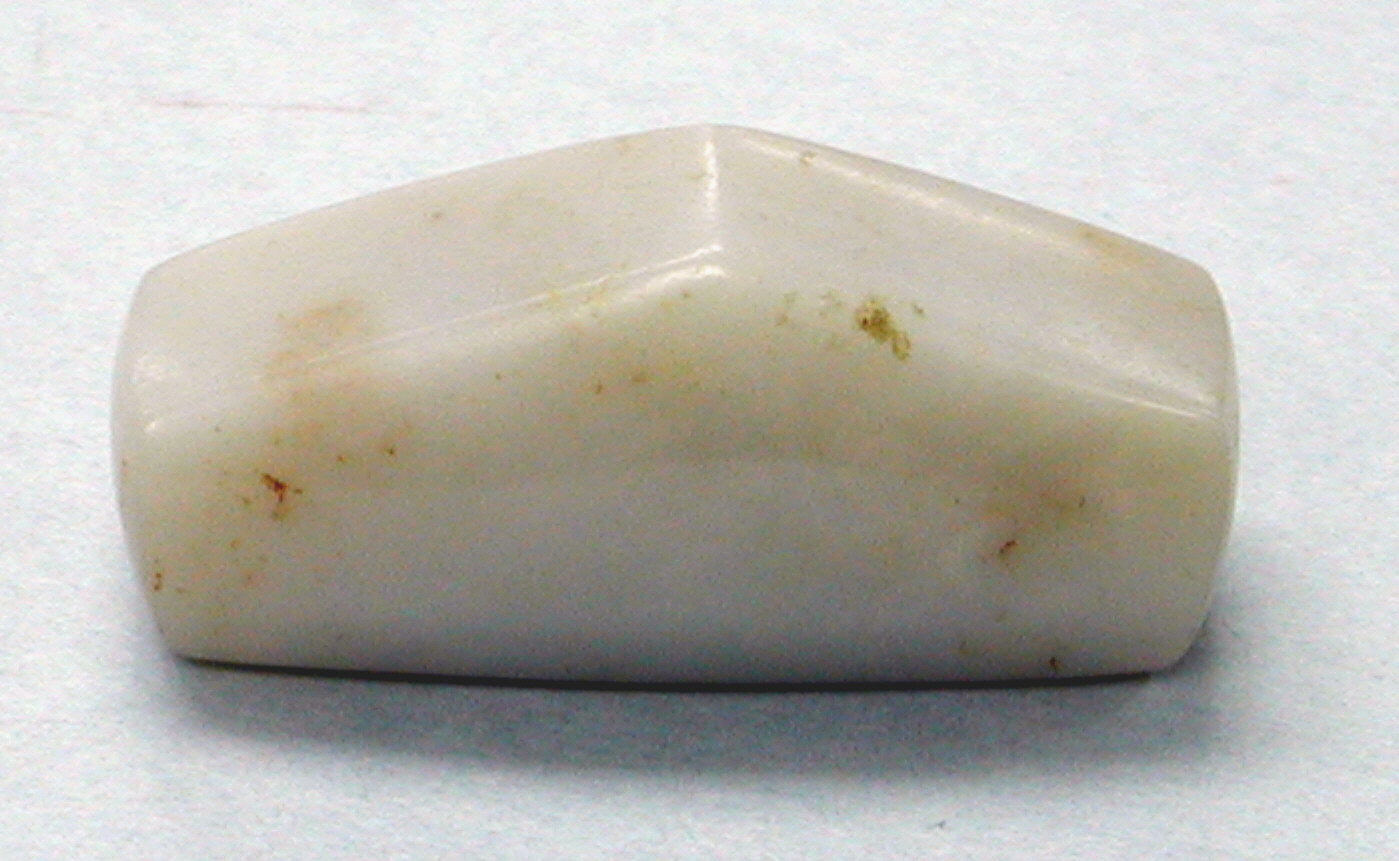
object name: ritual stone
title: Stone Pulidor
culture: mexican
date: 1501-1600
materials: stone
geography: mexico